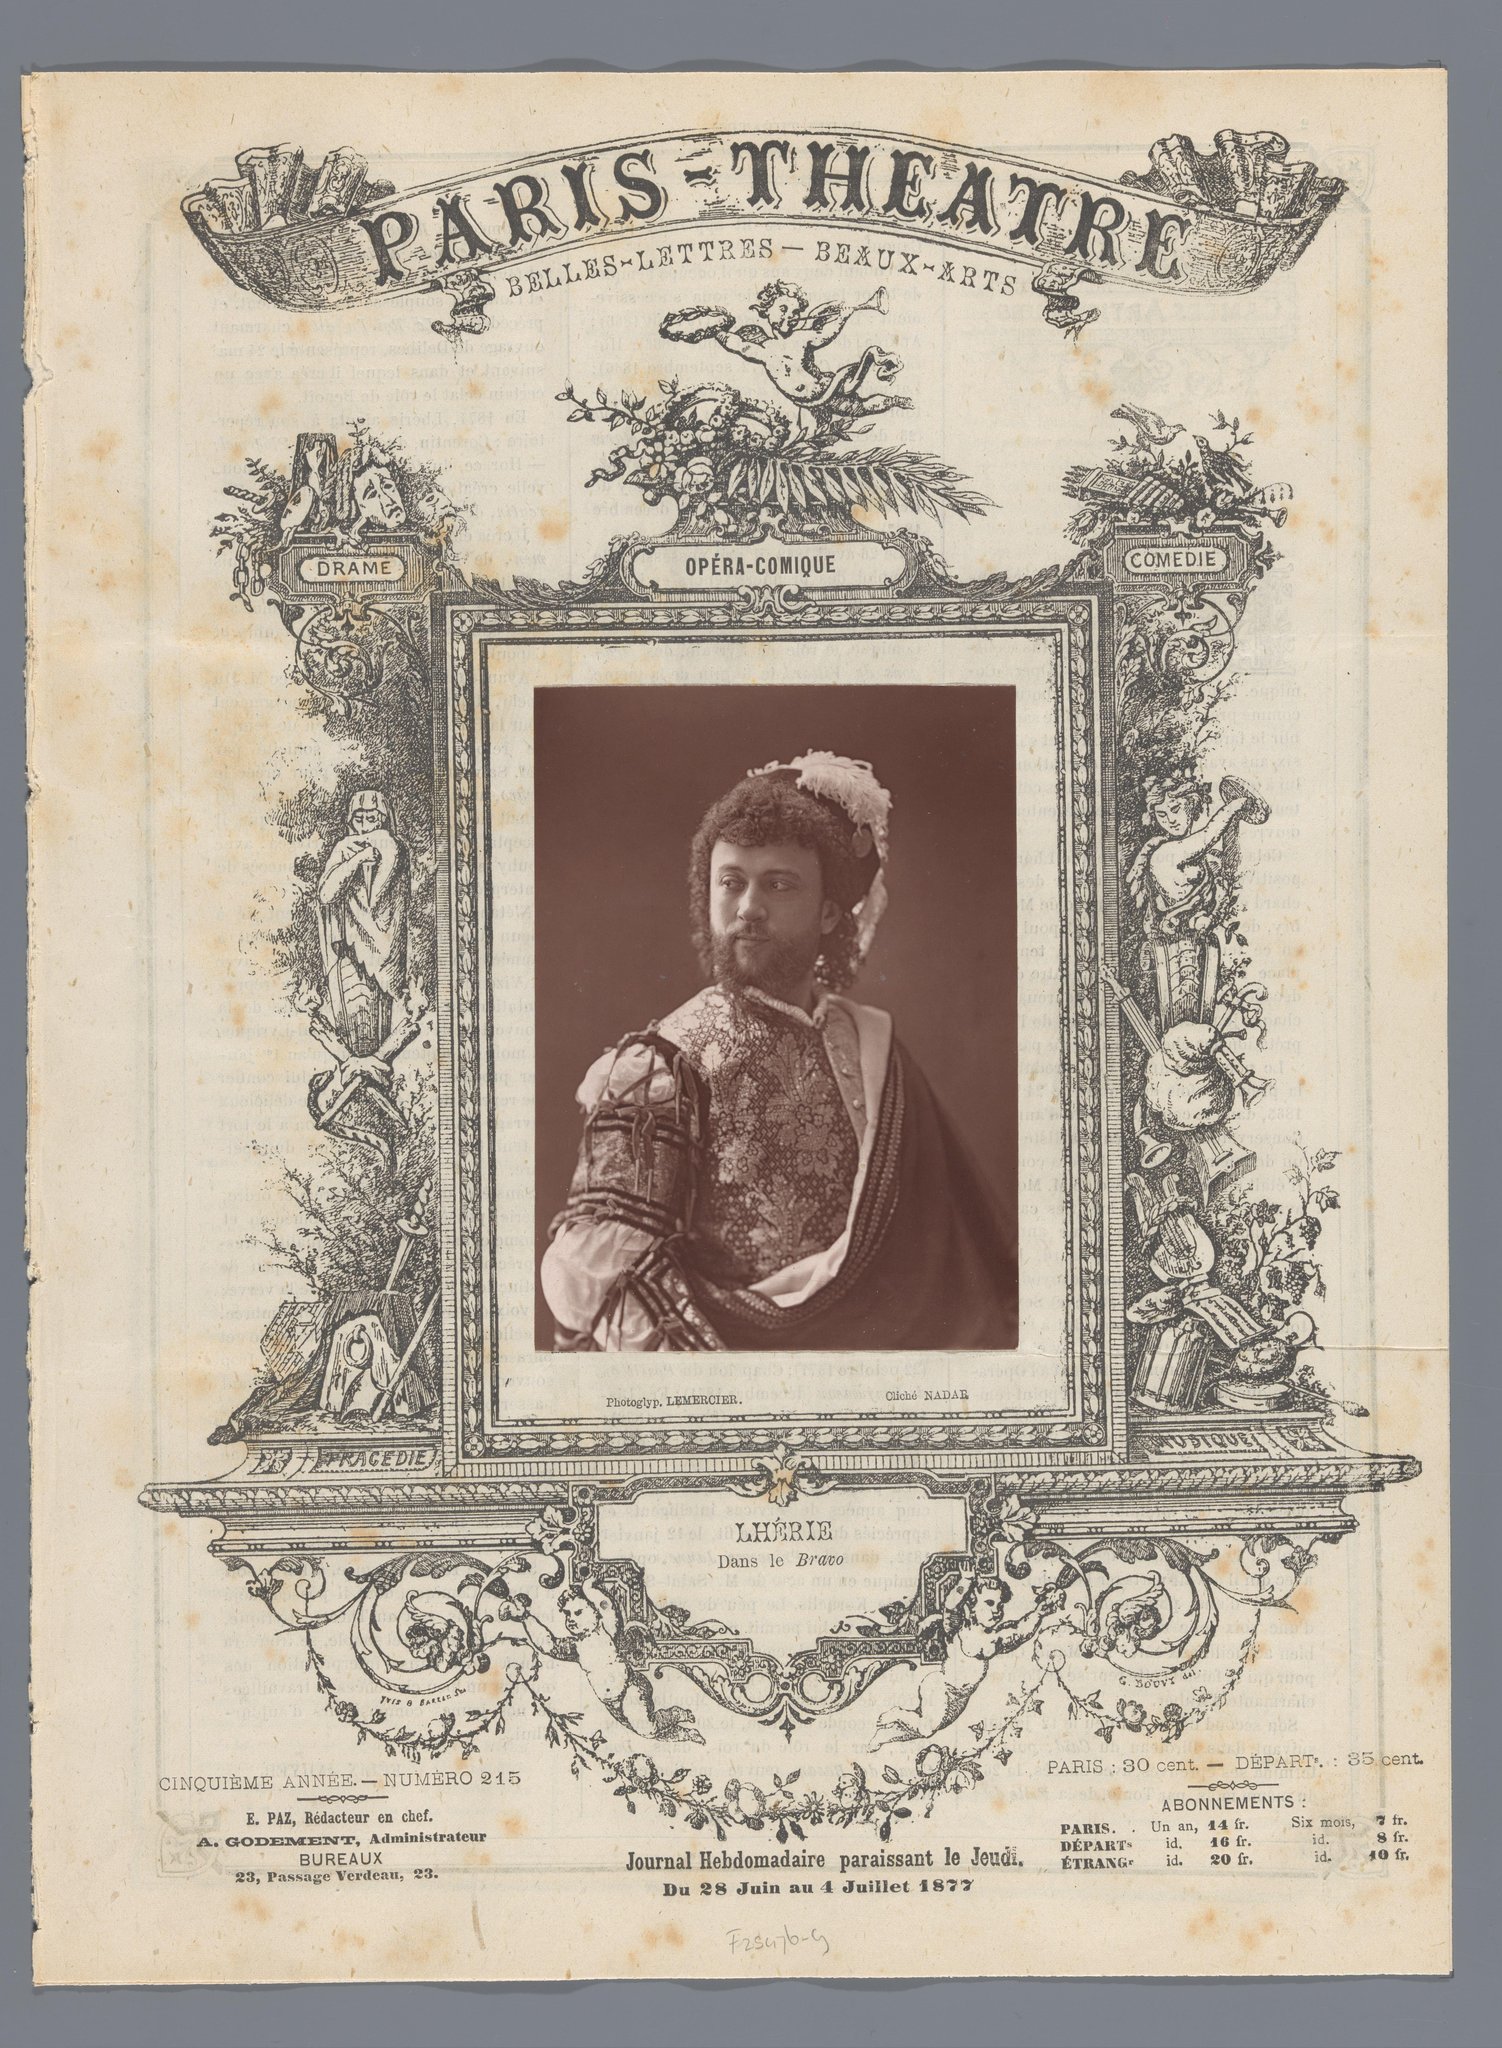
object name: photomechanical print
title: Lhérie, Dans le Bravo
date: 1872-1879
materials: paper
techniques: woodburytype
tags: paris, historical persons